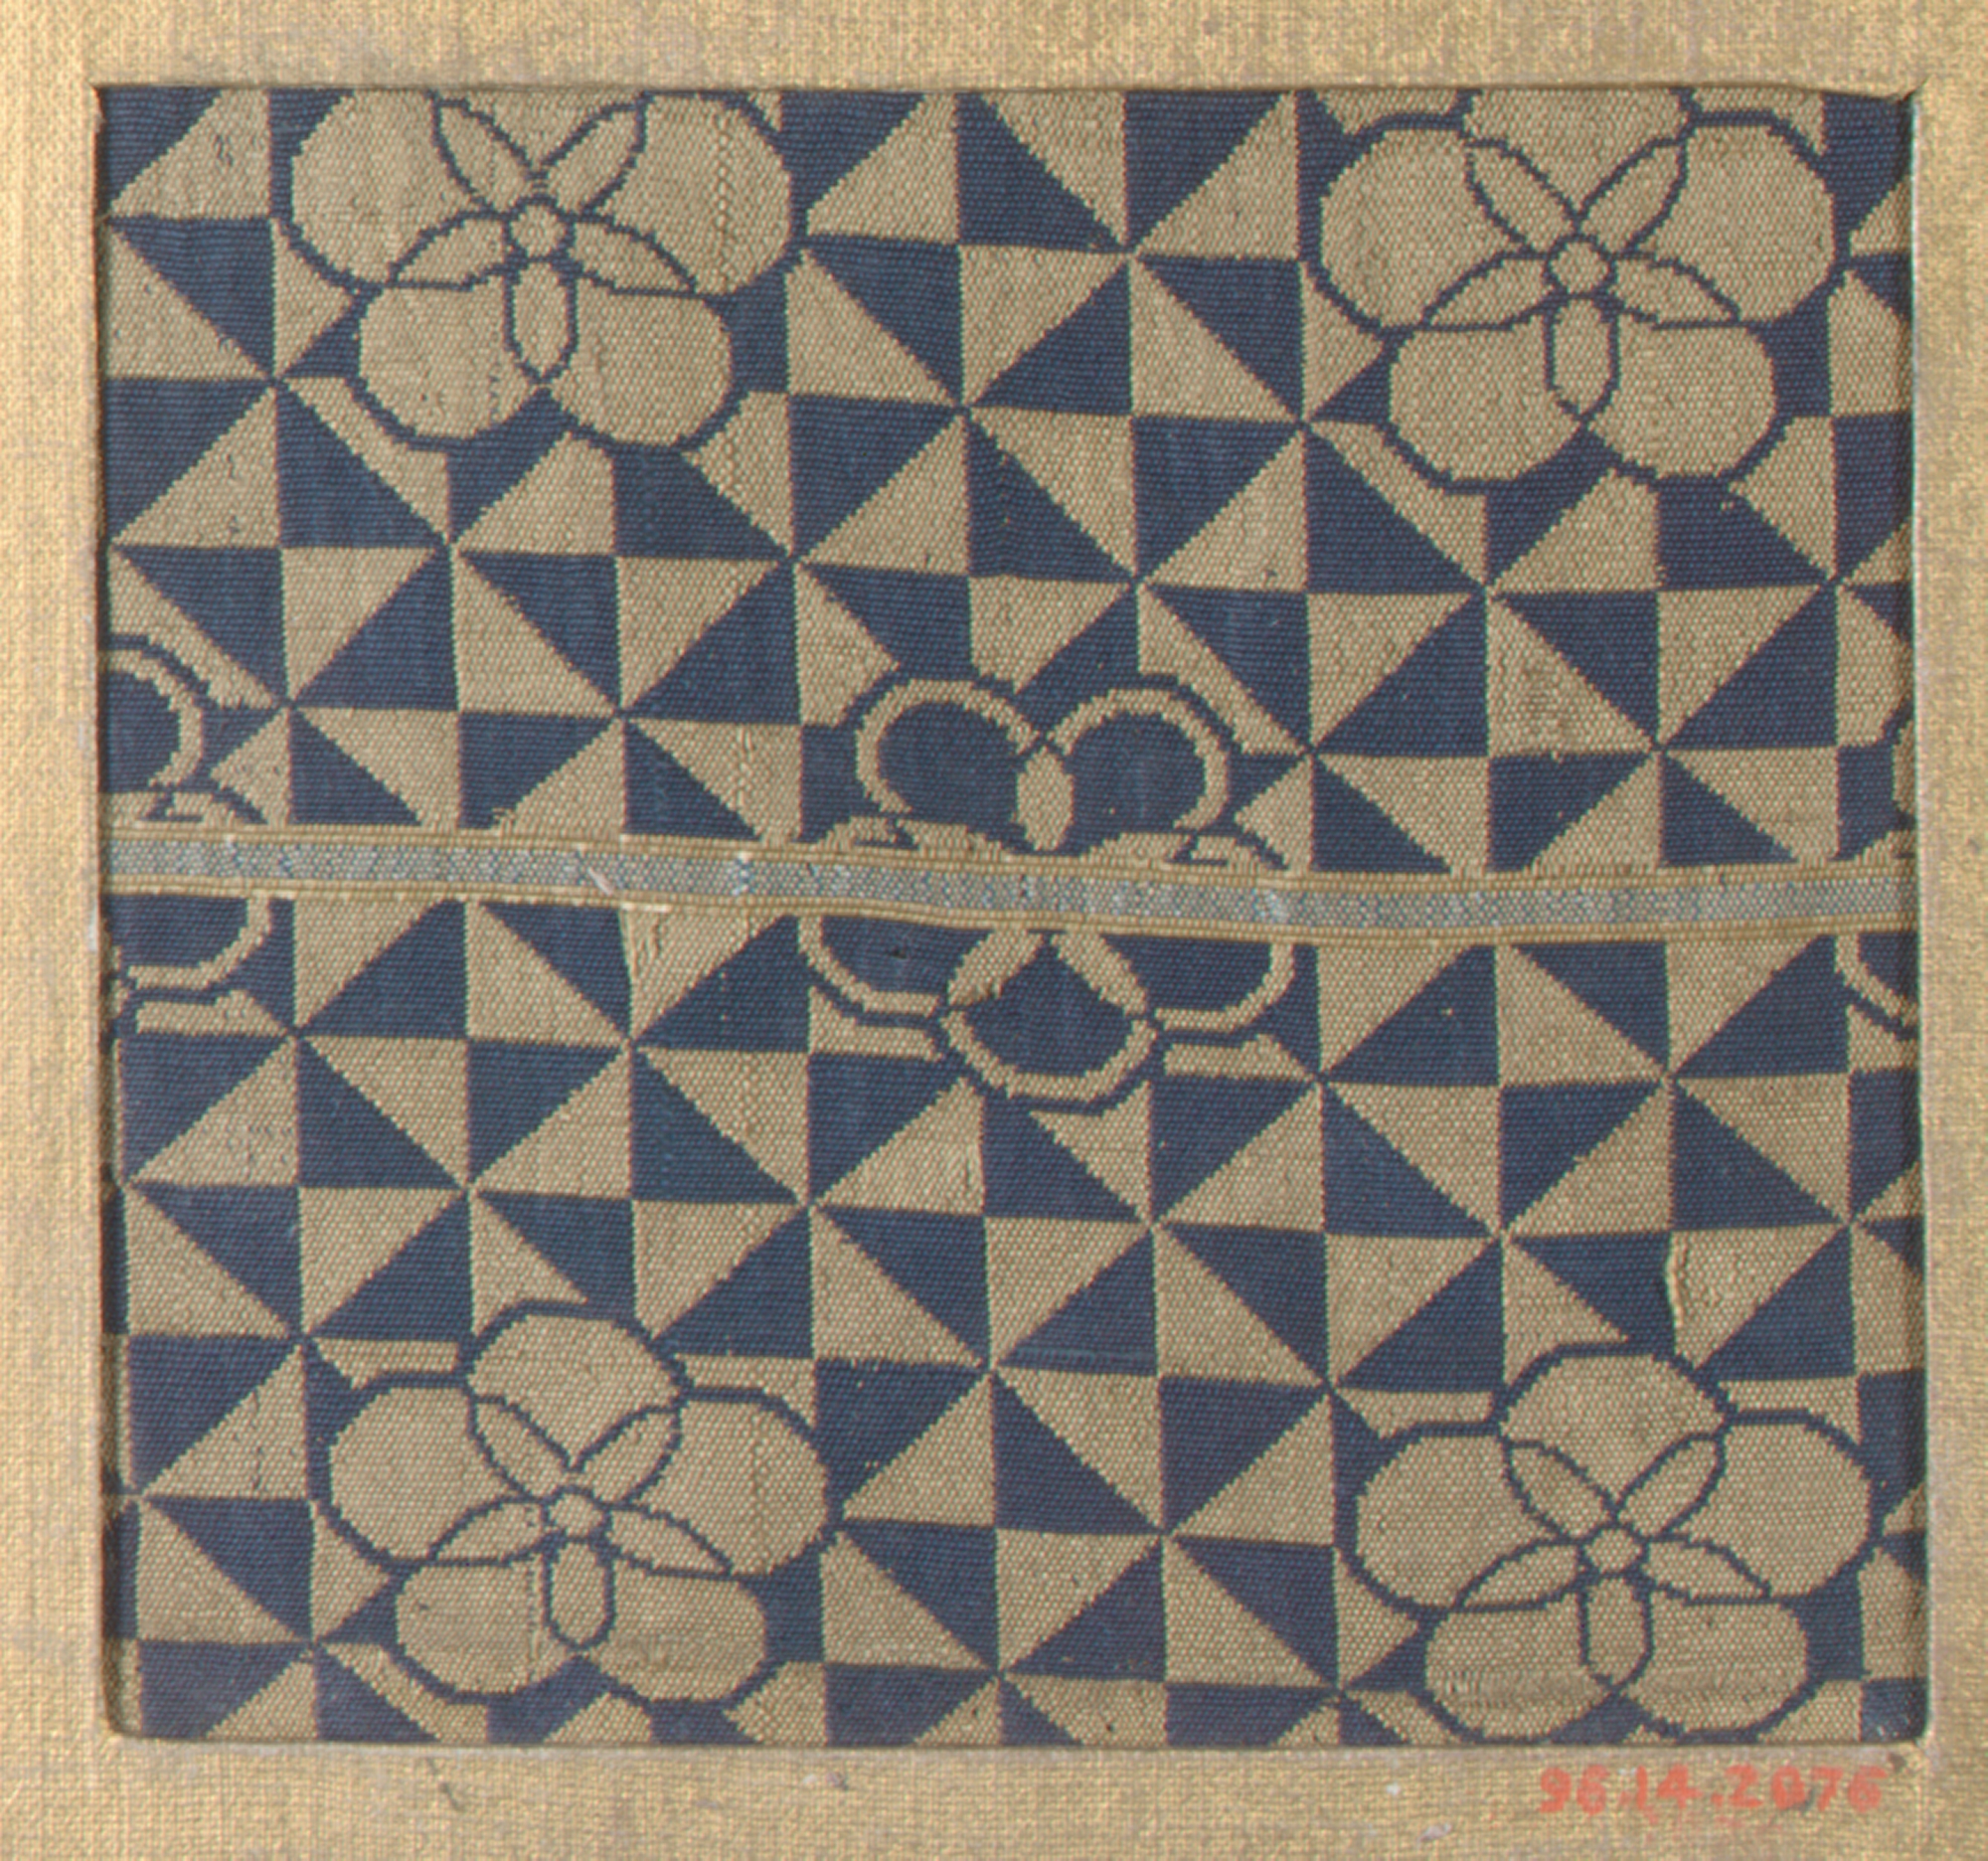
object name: piece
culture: japanese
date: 1701-1900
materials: silk